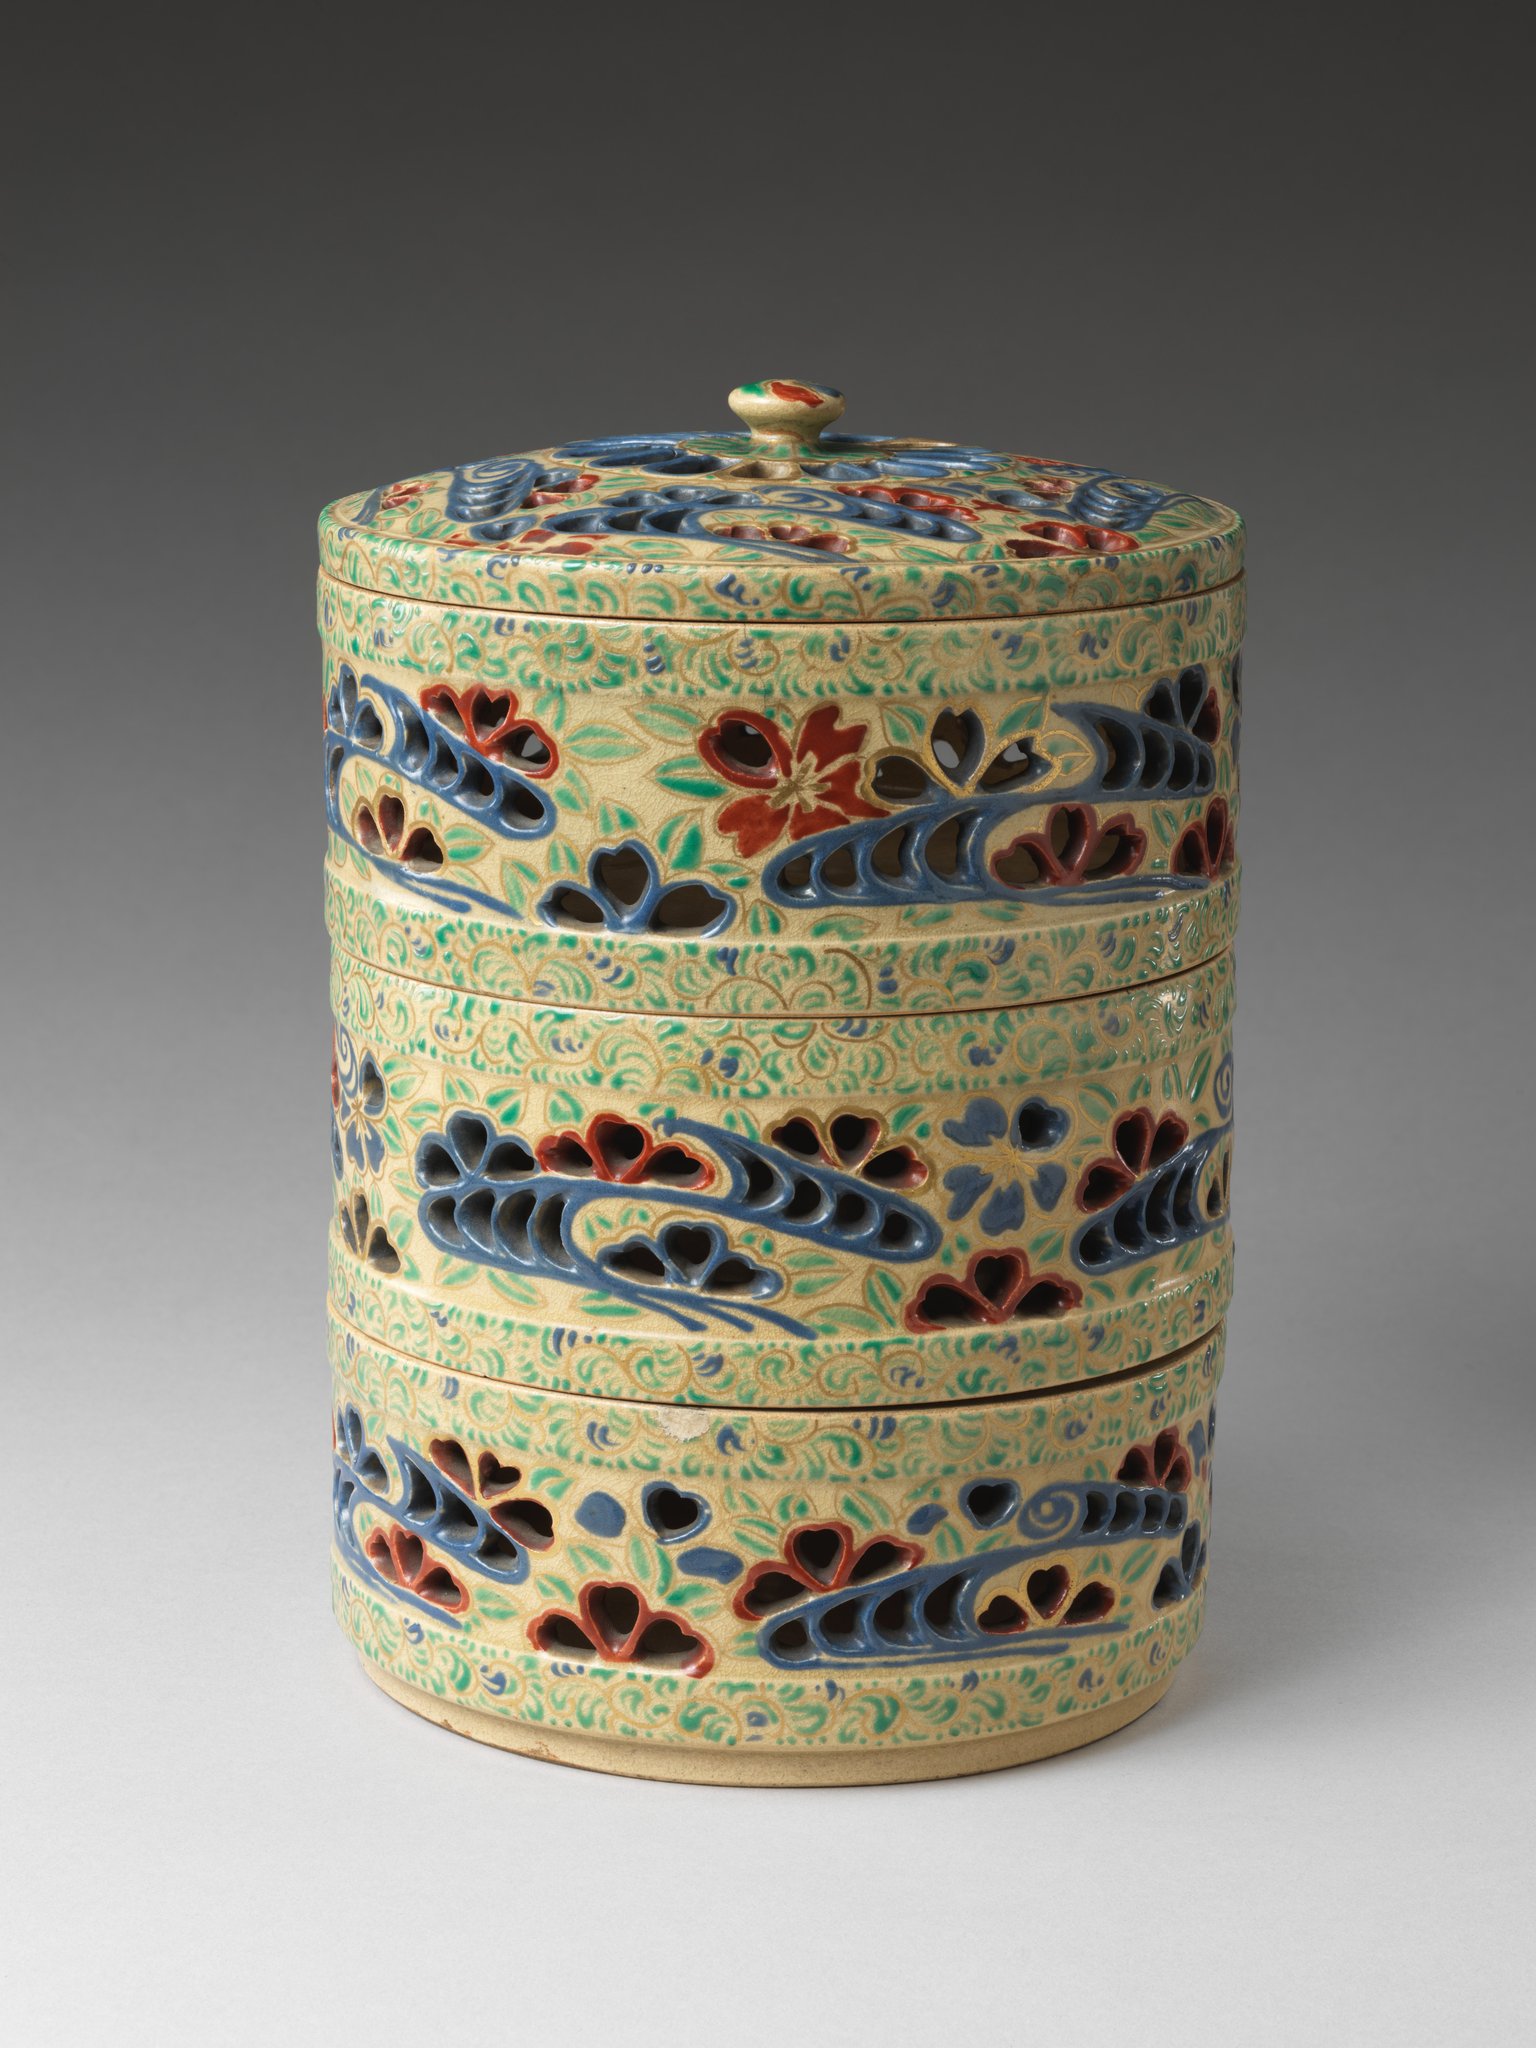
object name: tiered lunch box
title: Flowers Floating Down an Autumn Stream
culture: japanese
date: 1615-1868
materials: earthenware, glaze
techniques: polychrome